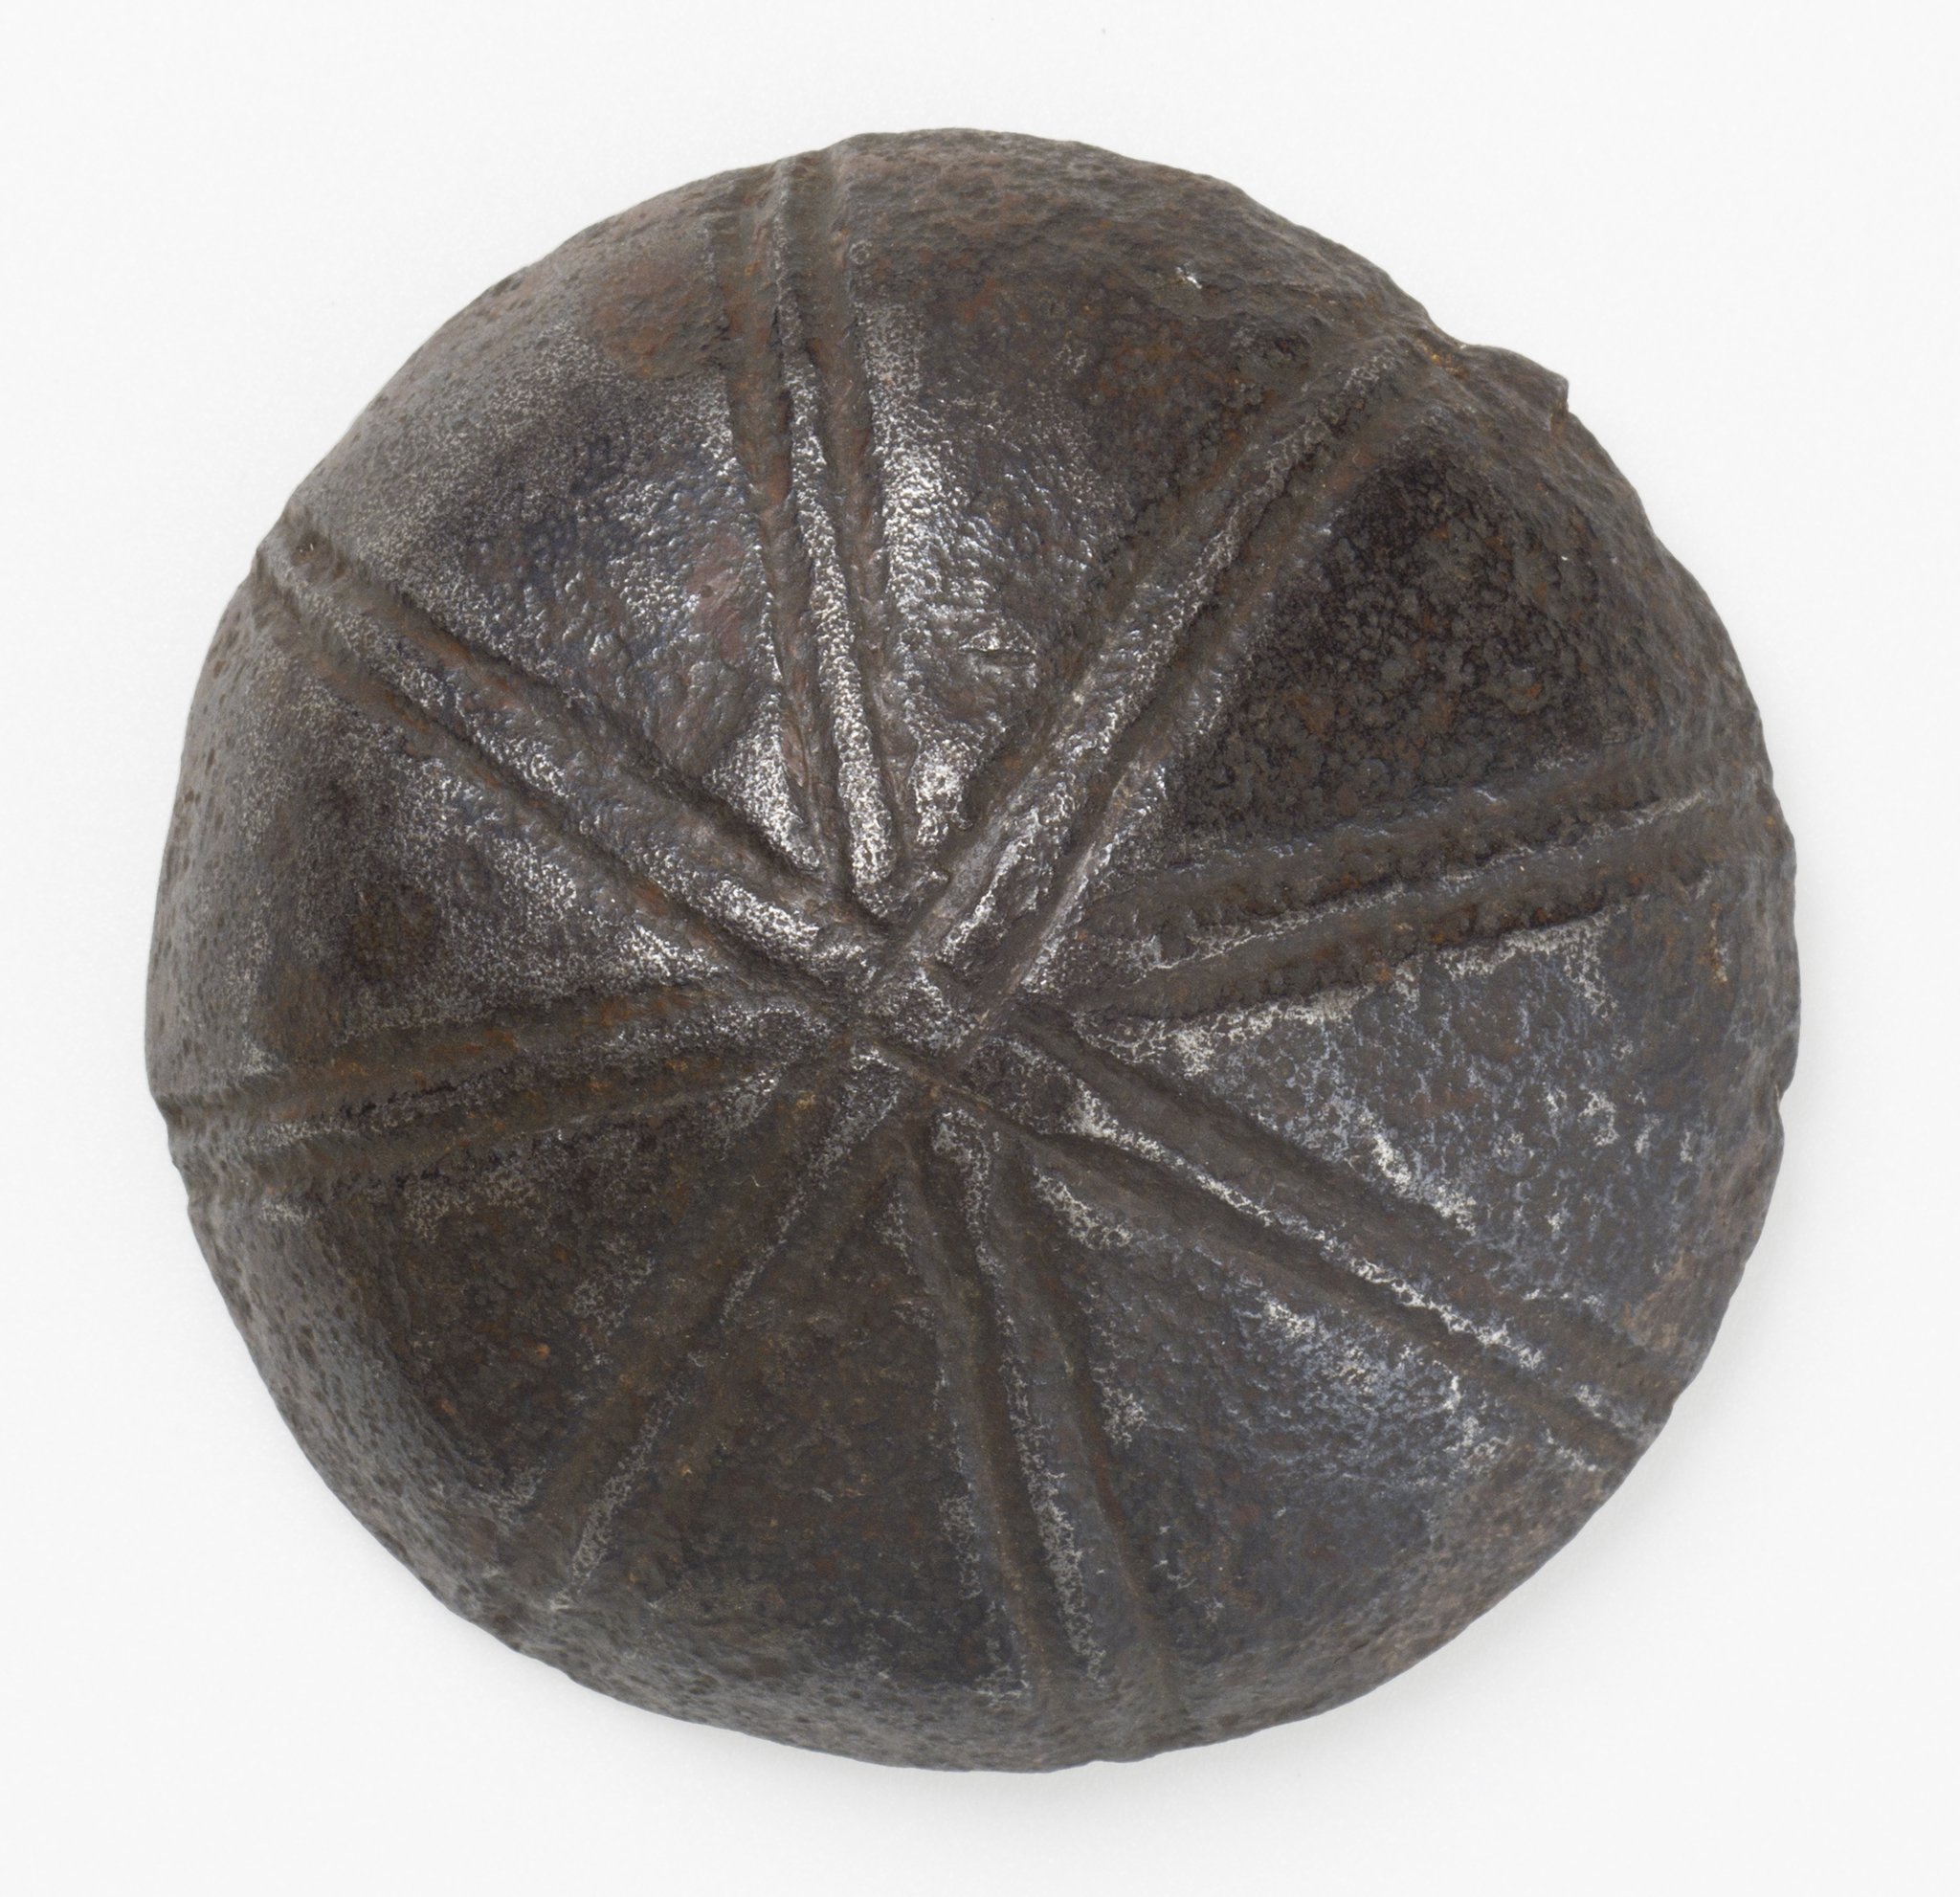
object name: nail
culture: european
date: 1401-1600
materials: iron